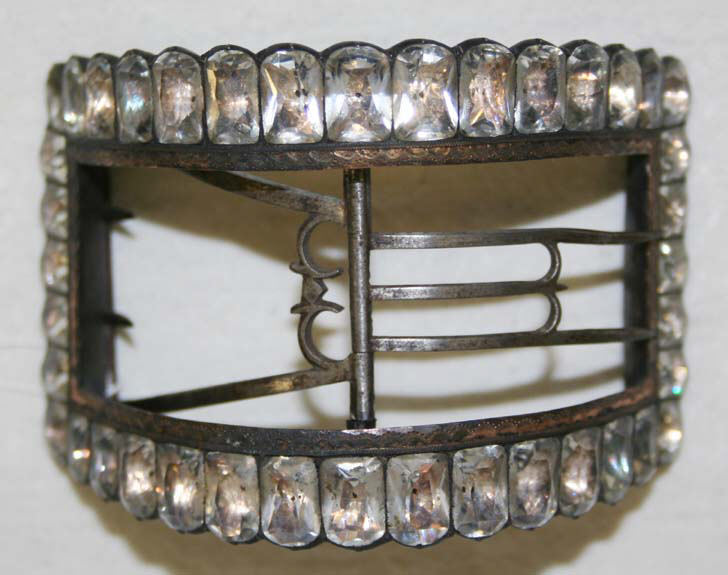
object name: shoe buckle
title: Shoe buckles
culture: british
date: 1767-1800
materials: metal, paste